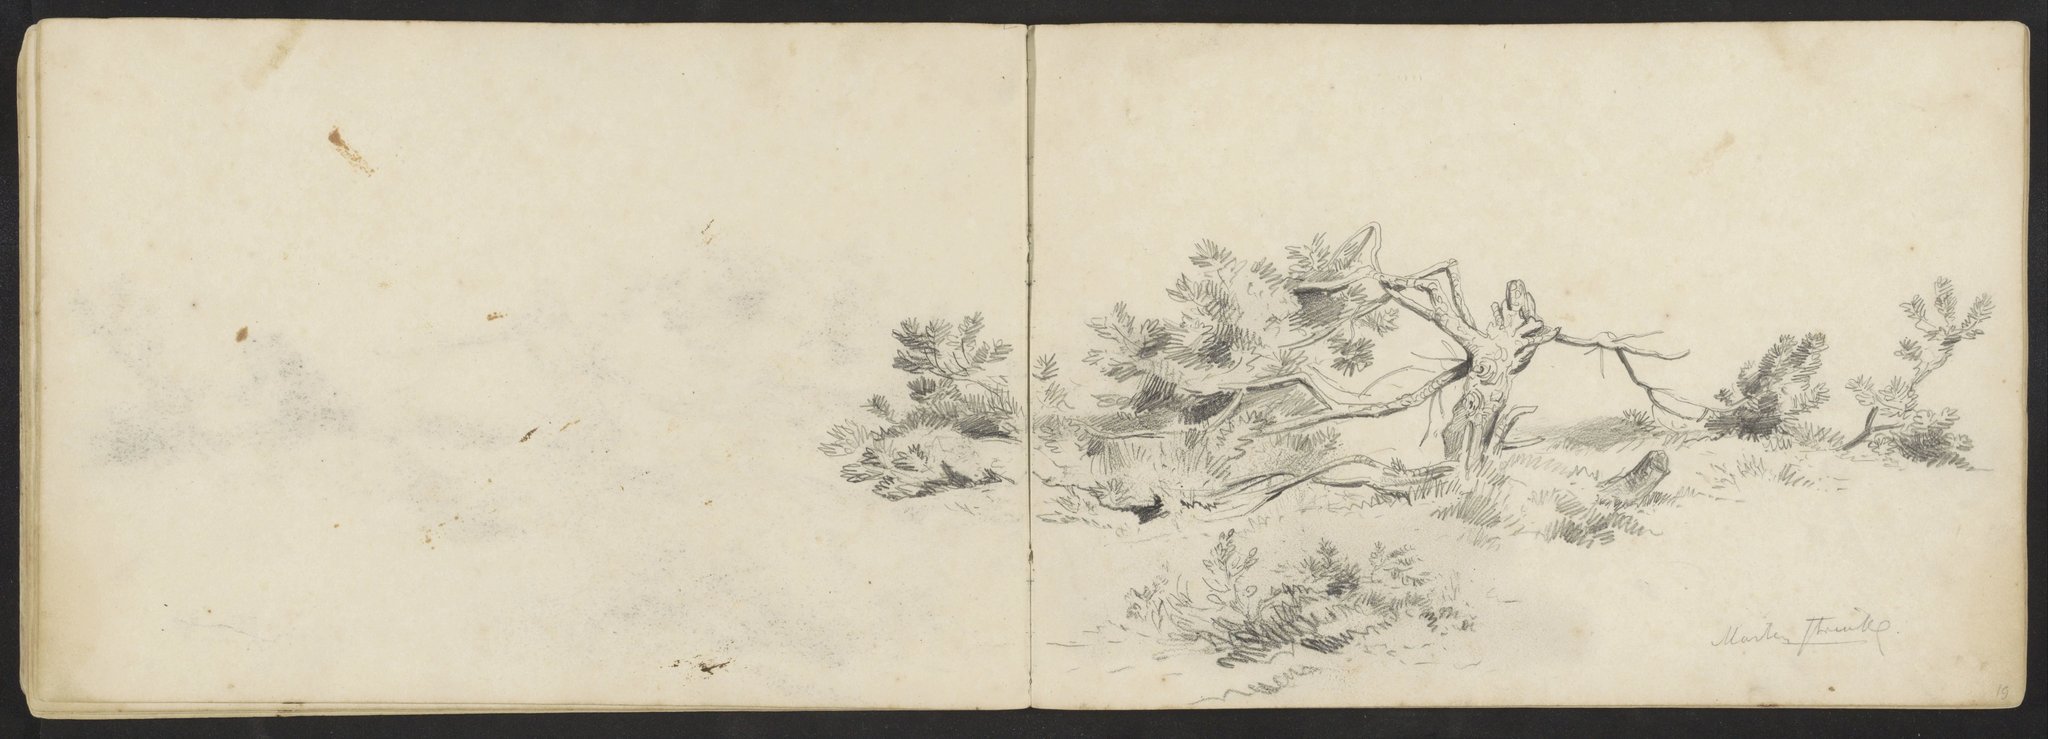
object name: sketchbook leaf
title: Heide met een boom met platgewaaide takken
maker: johannes tavenraat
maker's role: draughtsman, painter, print maker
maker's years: 1809-1881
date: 1842-1868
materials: paper, pencil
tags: trees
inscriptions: annotation: ‘Ma[...]ten struik.’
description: Blad 18 verso en 19 recto uit een schetsboek met 45 bladen.